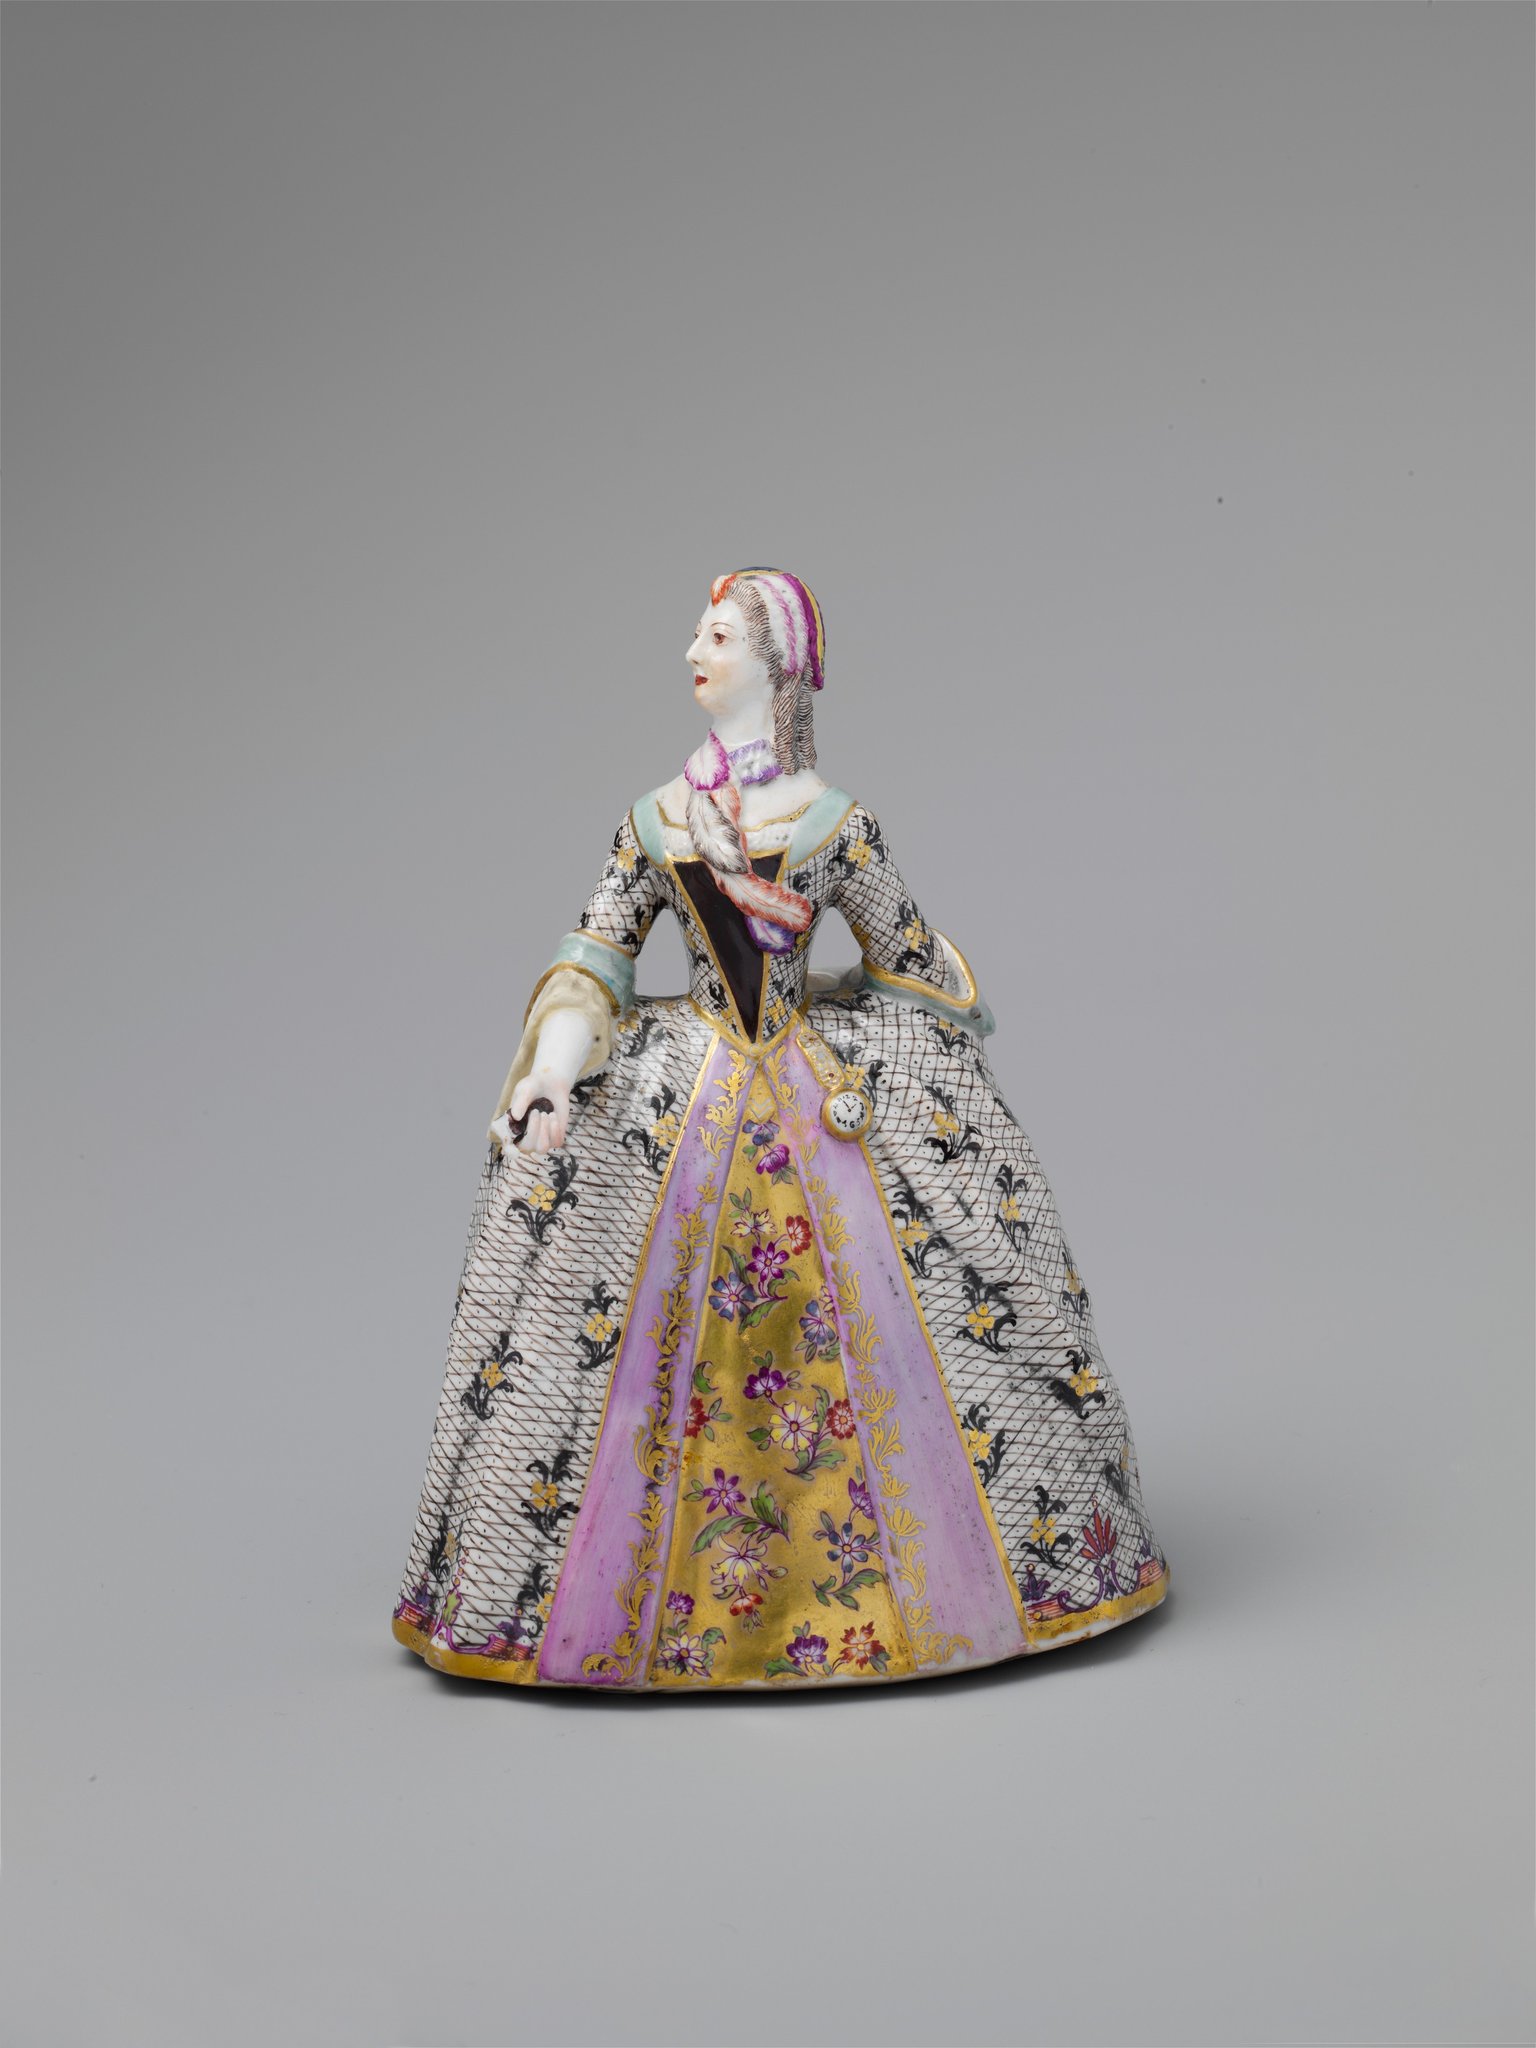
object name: figure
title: Standing woman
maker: imperial porcelain manufactory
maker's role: manufactory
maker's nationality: austrian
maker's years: 1744-1864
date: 1744-1749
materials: hard paste porcelain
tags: women